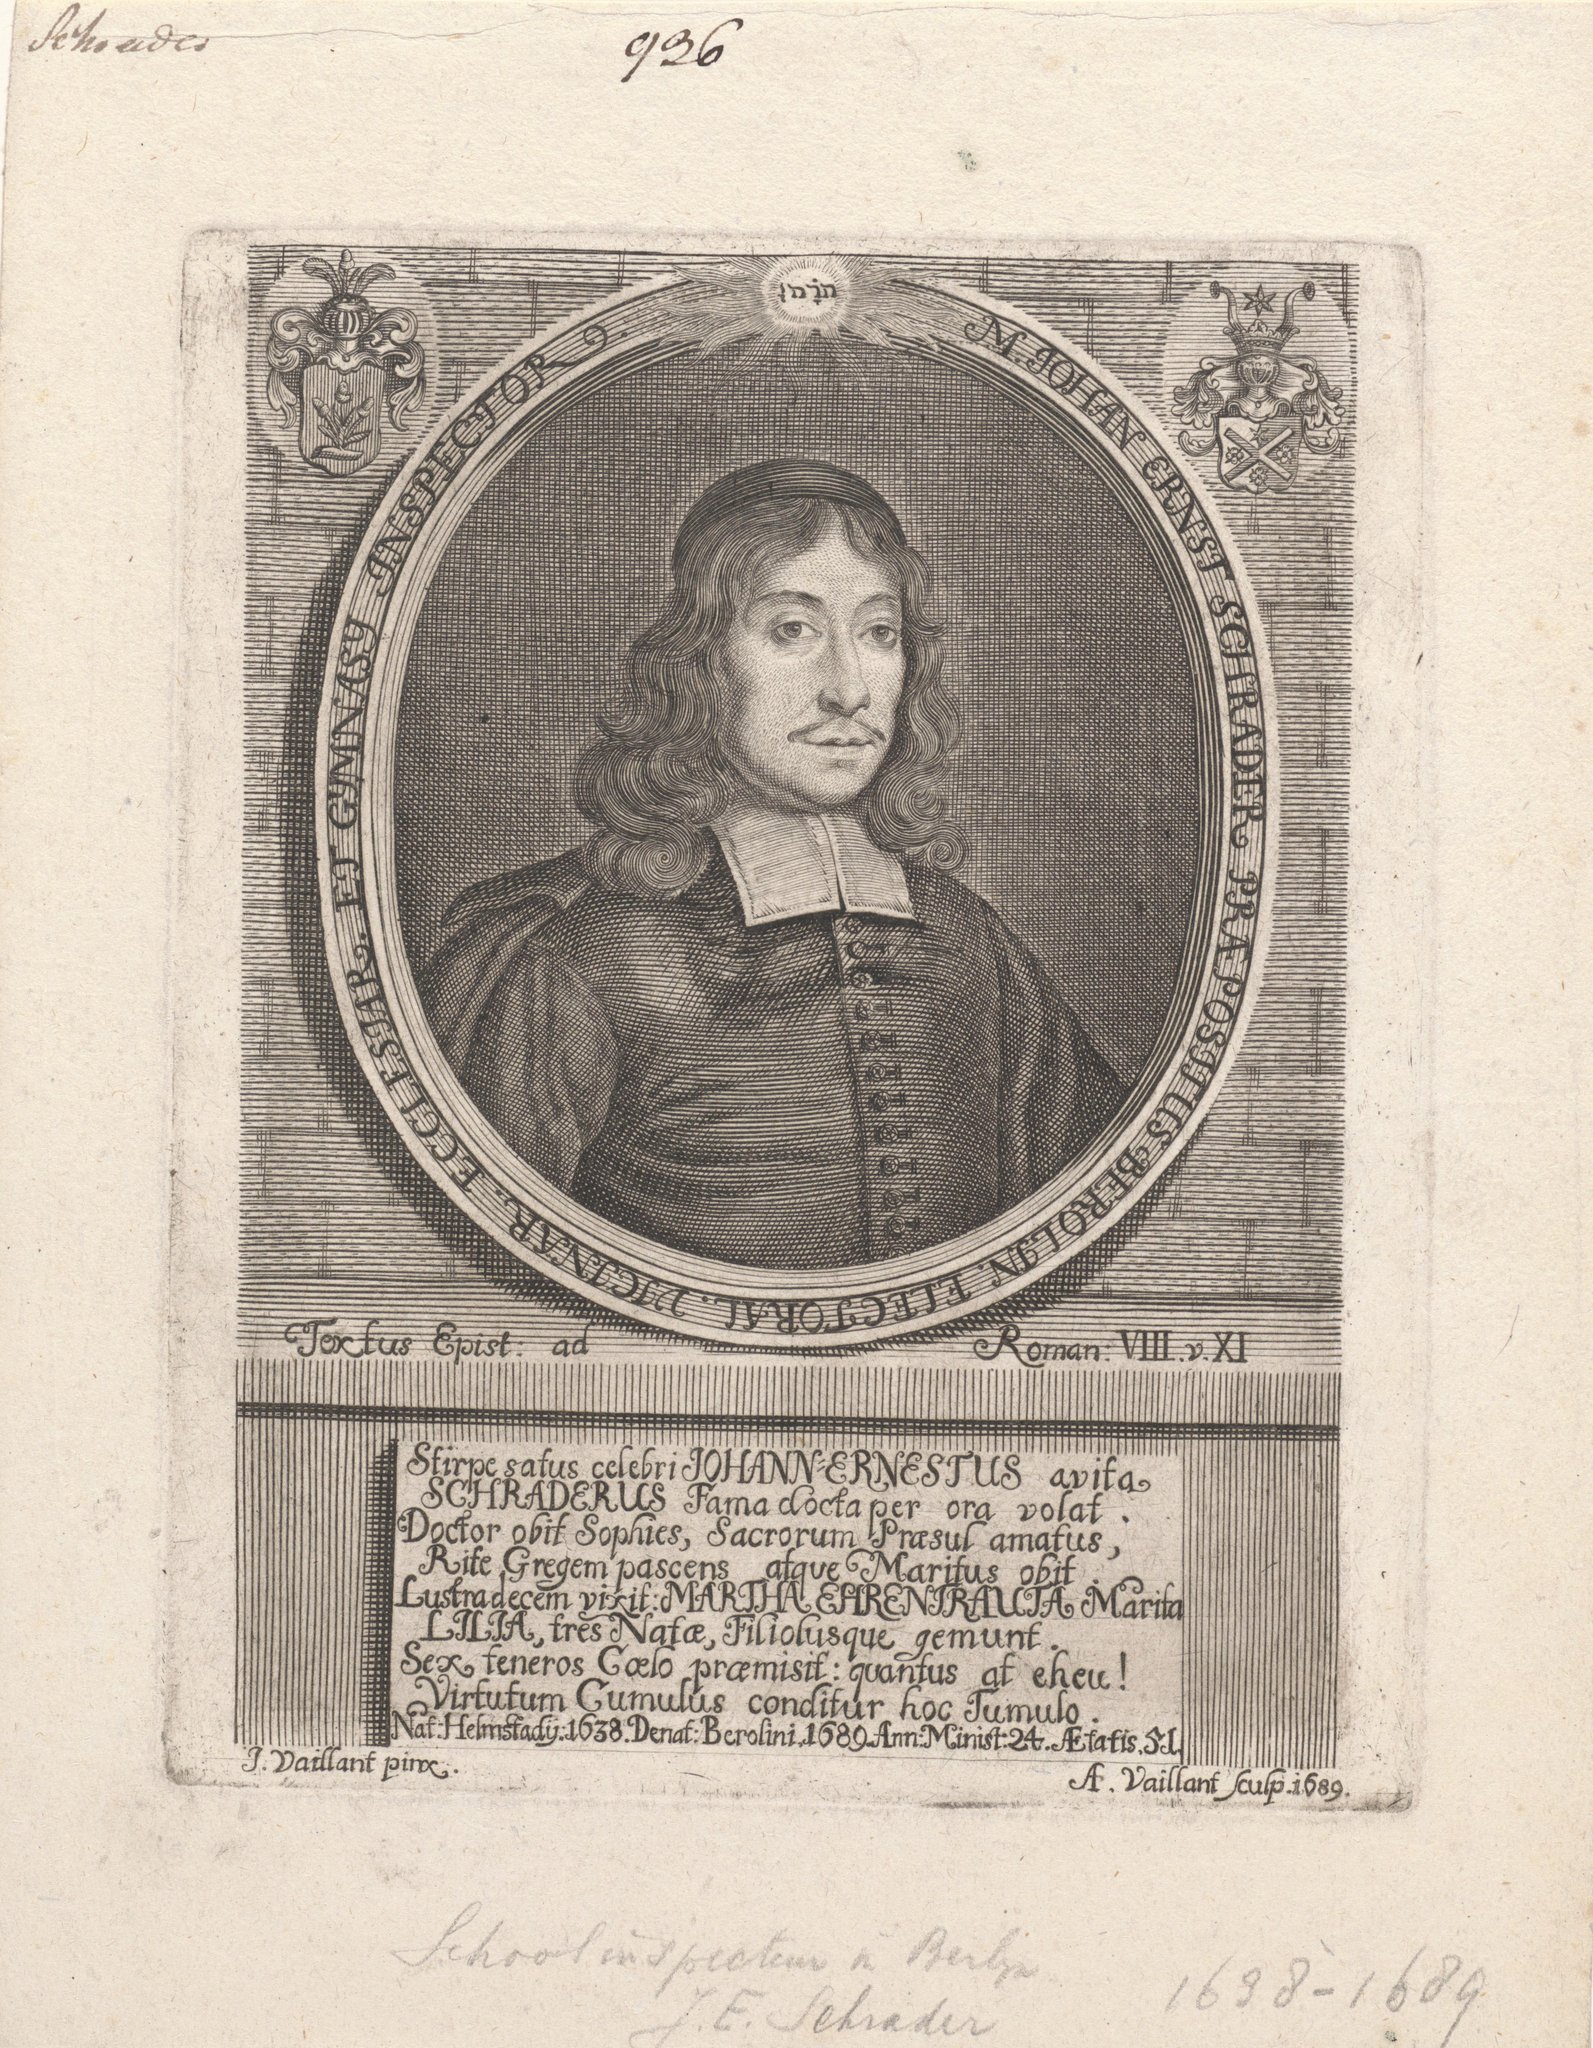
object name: print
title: Portret van de predikant Johann Ernst Schrader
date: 1689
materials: paper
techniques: engraving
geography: berlin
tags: berlin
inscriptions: collector's mark: Lugt 2228, inscription: ‘Schrader/ 936’